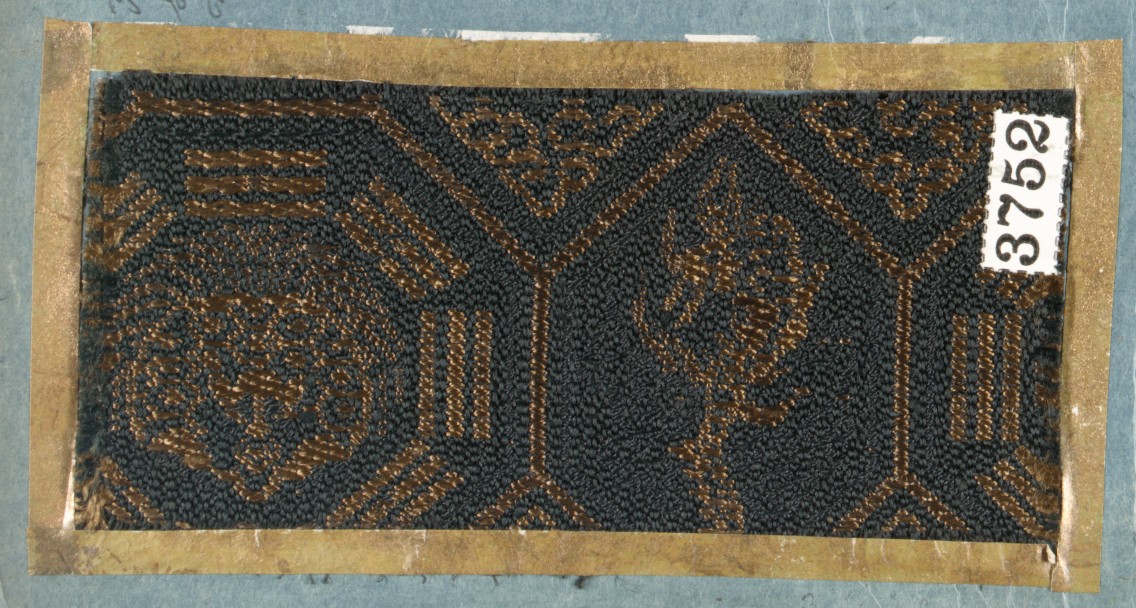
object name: sample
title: Textile Sample from Sample Book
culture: japanese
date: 1801-1900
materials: silk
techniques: tapestry